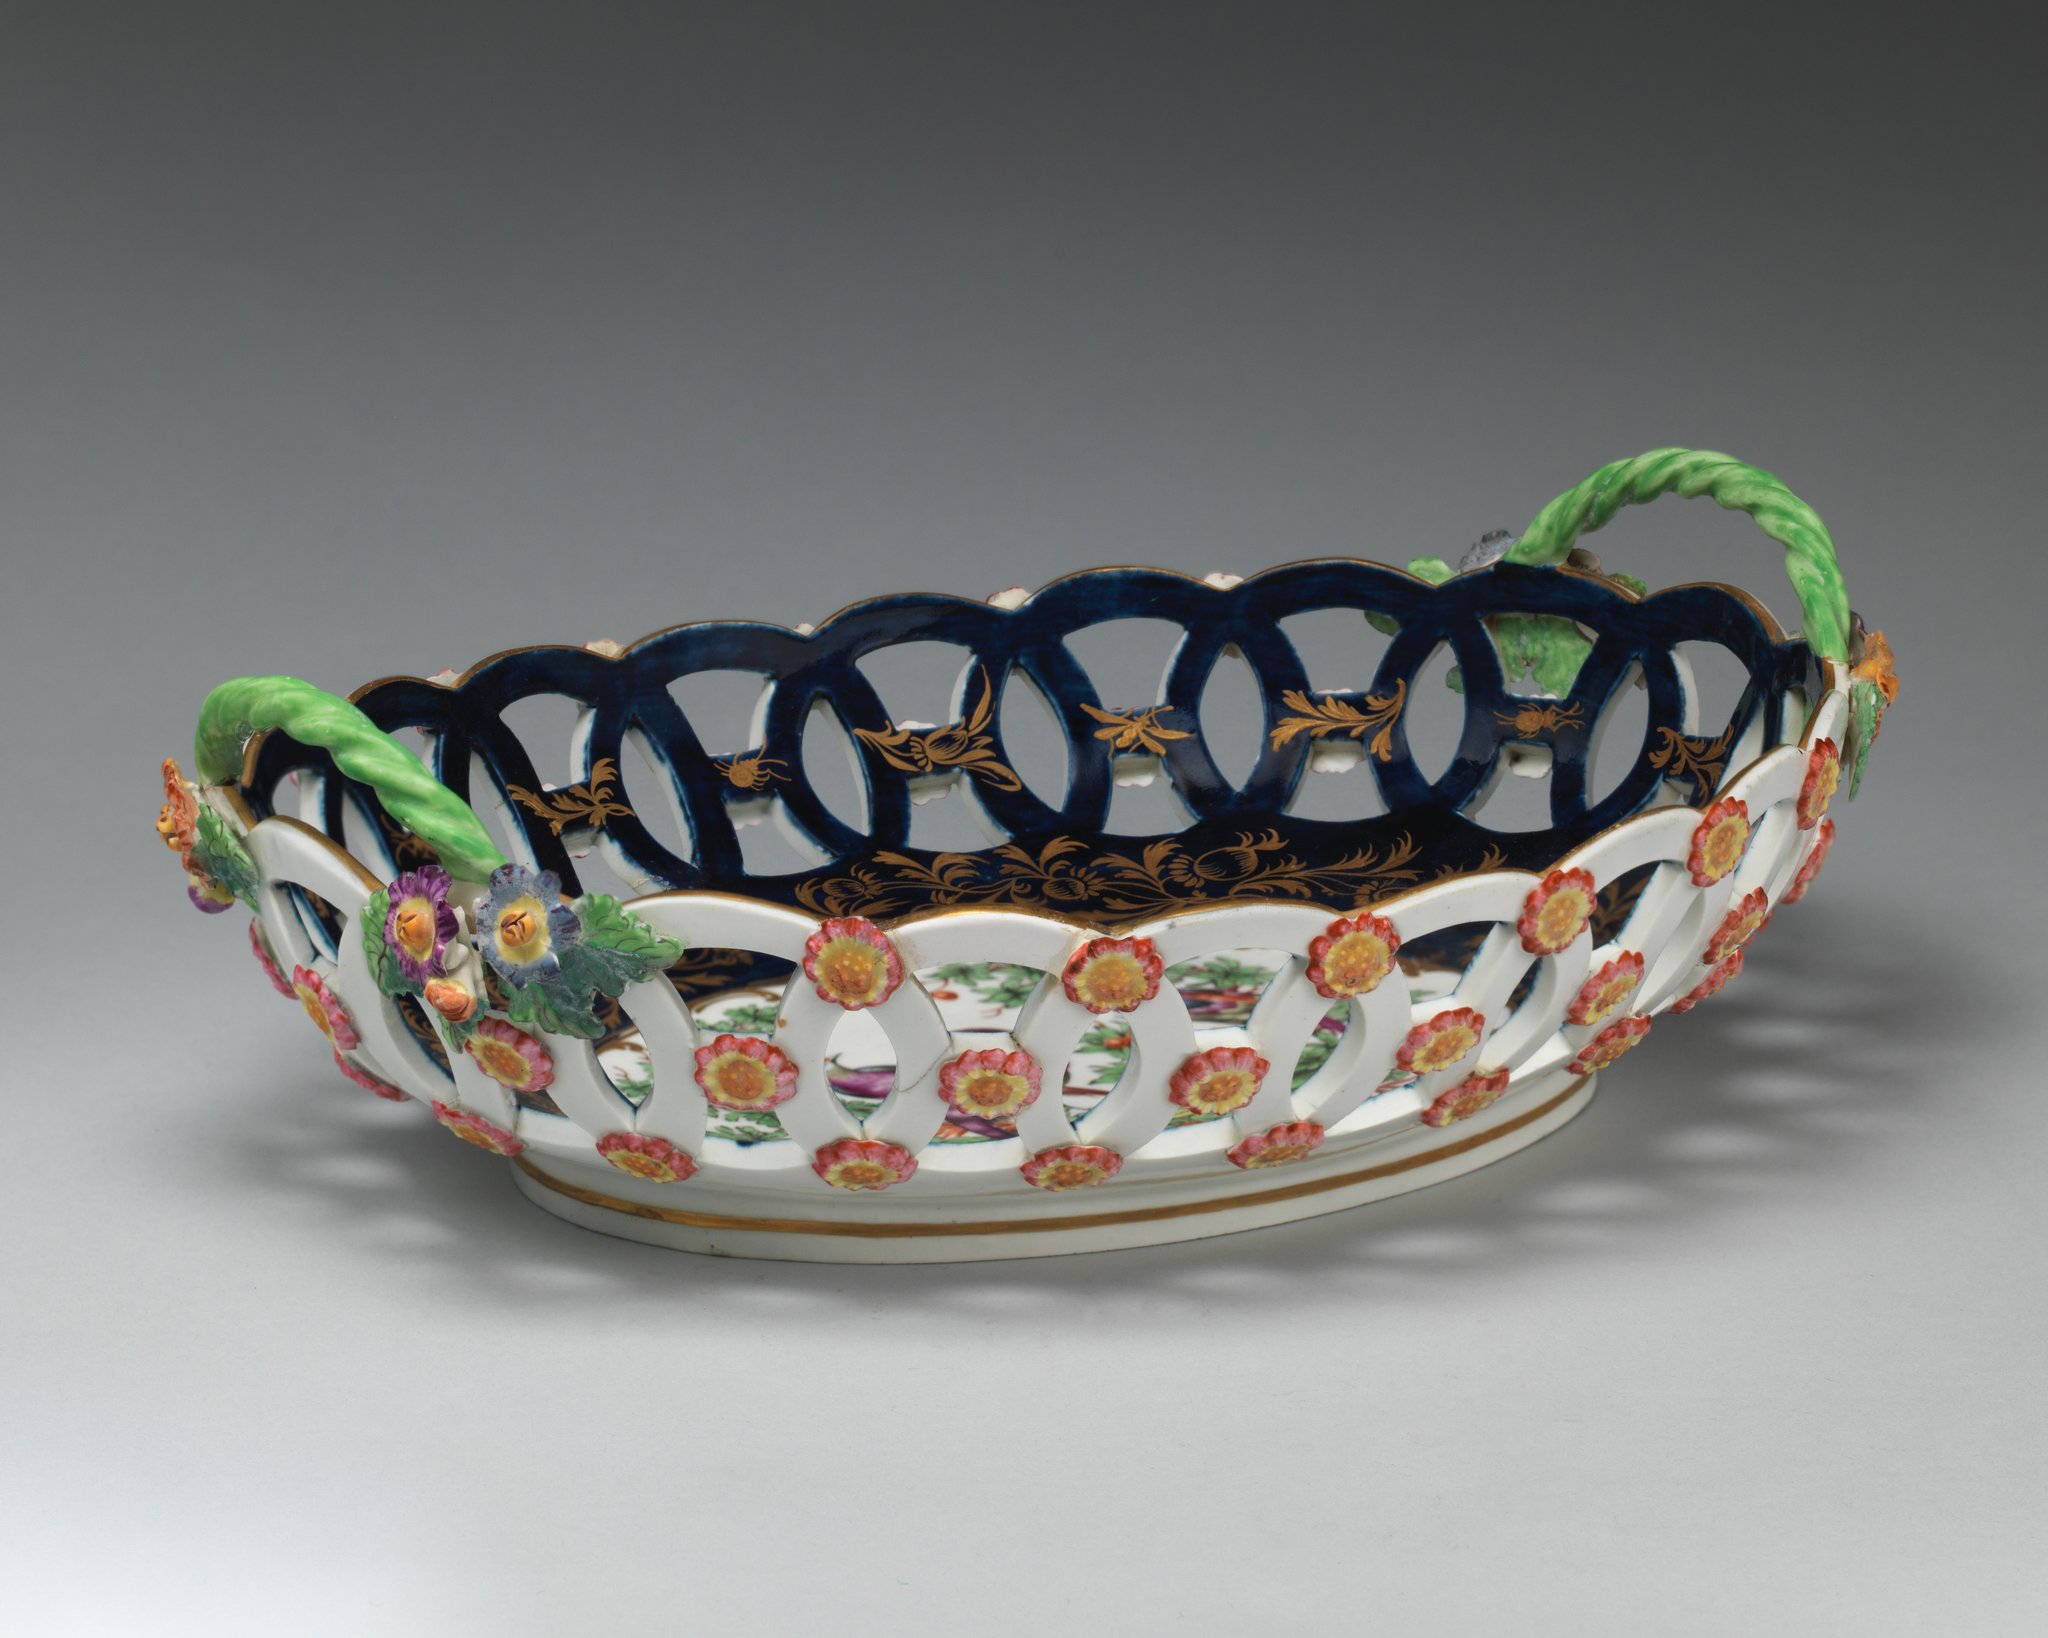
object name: basket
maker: worcester factory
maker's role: factory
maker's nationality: british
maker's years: 1751-2008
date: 1770-1775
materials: soft paste porcelain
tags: flowers